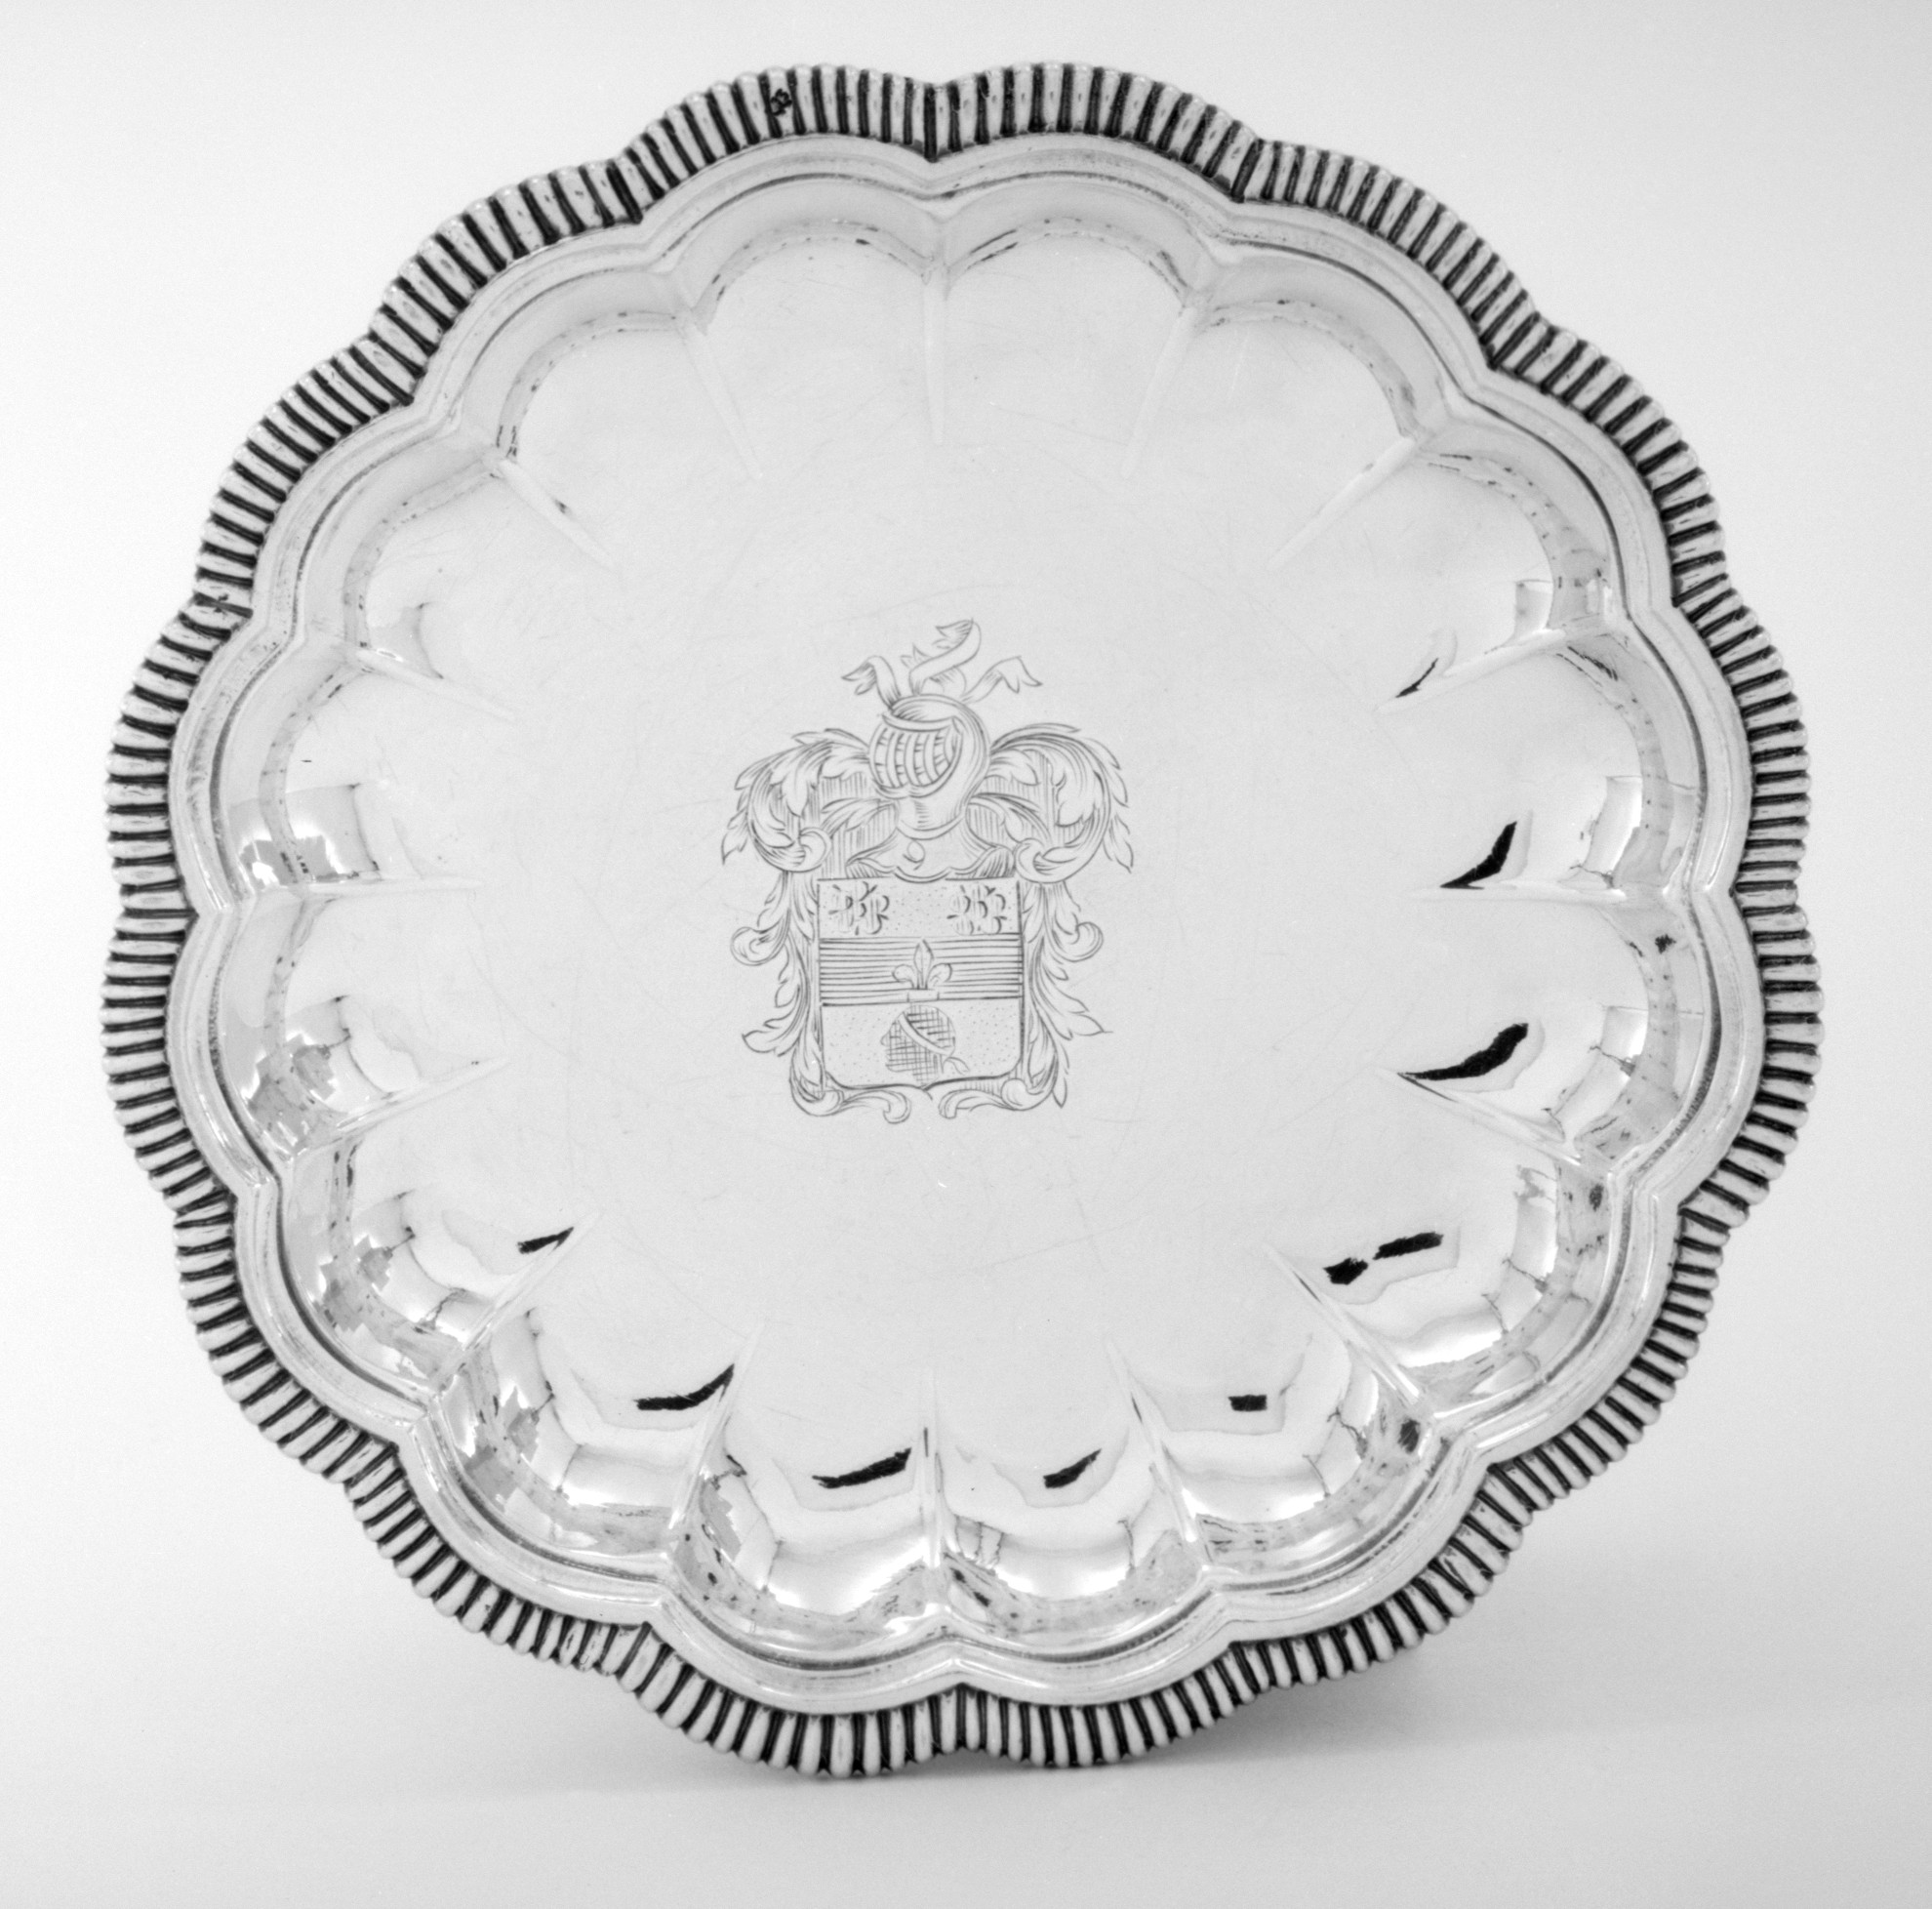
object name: dish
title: Dish (one of a pair)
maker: i d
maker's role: maker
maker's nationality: british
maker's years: 1650-1699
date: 1729-1730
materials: silver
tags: coat of arms